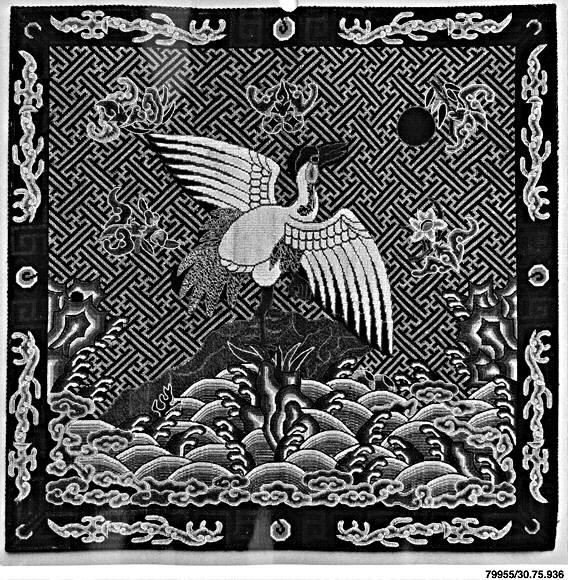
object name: rank badge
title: Rank Badge with Crane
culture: chinese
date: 1801-1900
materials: silk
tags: bats,cranes